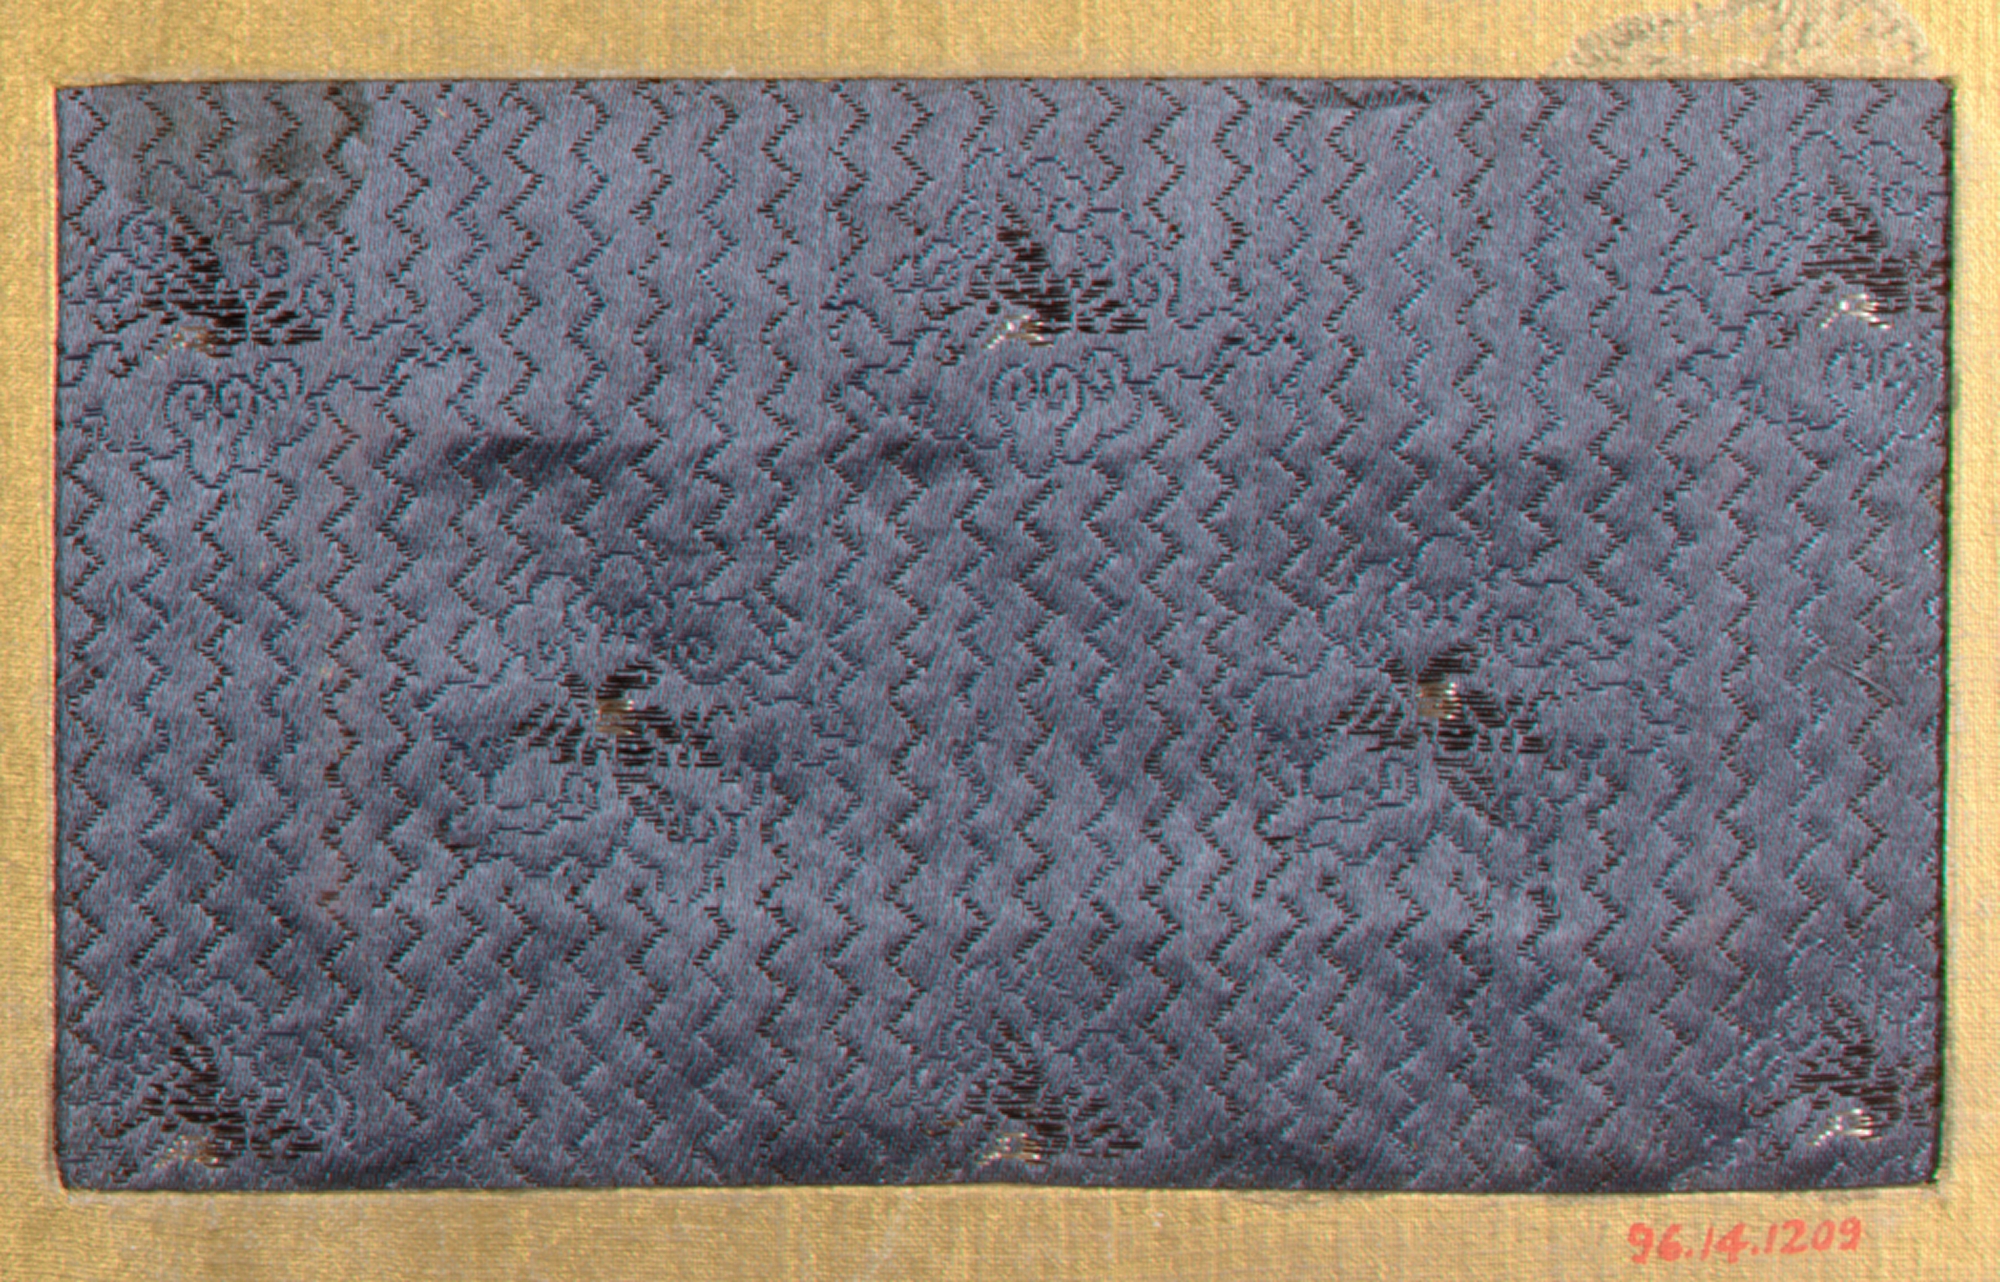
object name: piece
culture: japanese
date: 1701-1900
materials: silk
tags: birds